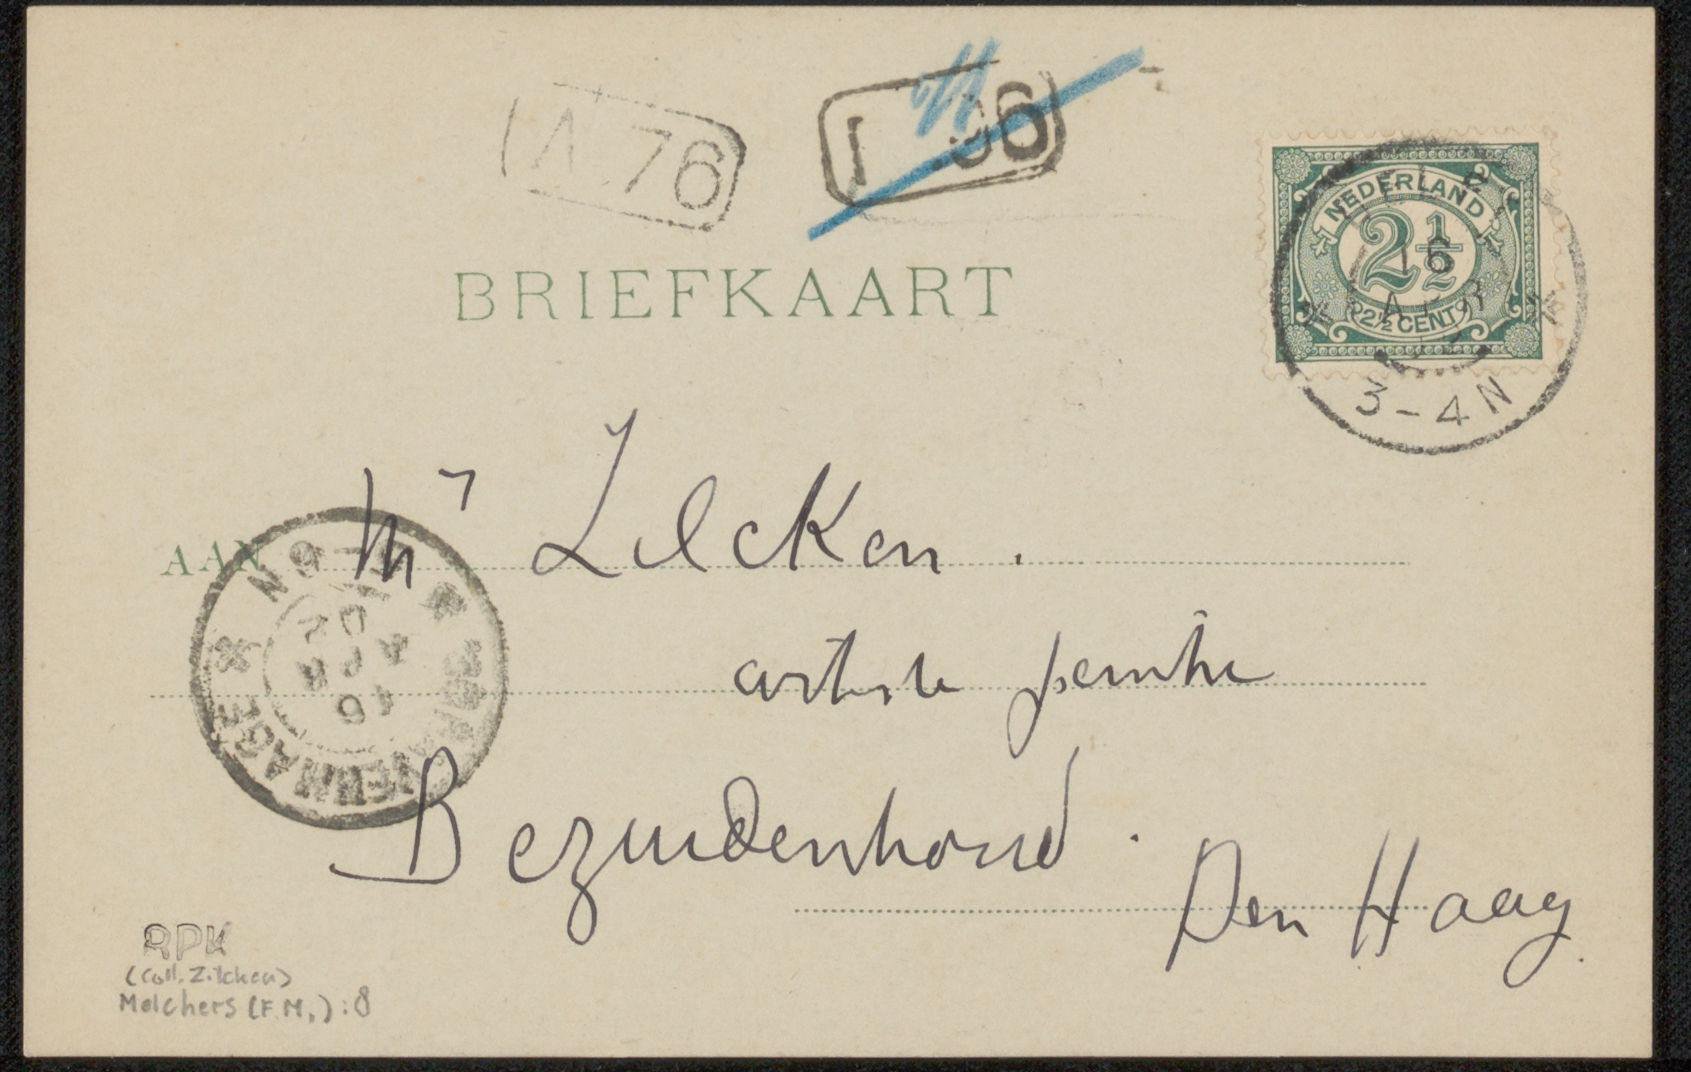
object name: postcard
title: Briefkaart aan Philip Zilcken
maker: franz melchers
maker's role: draughtsman, painter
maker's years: 1868-1944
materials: cardboard, ink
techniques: pen, writing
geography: delft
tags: cyriel buysse, philip zilcken, photography, cinematography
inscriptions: collector's mark: ‘RPK’